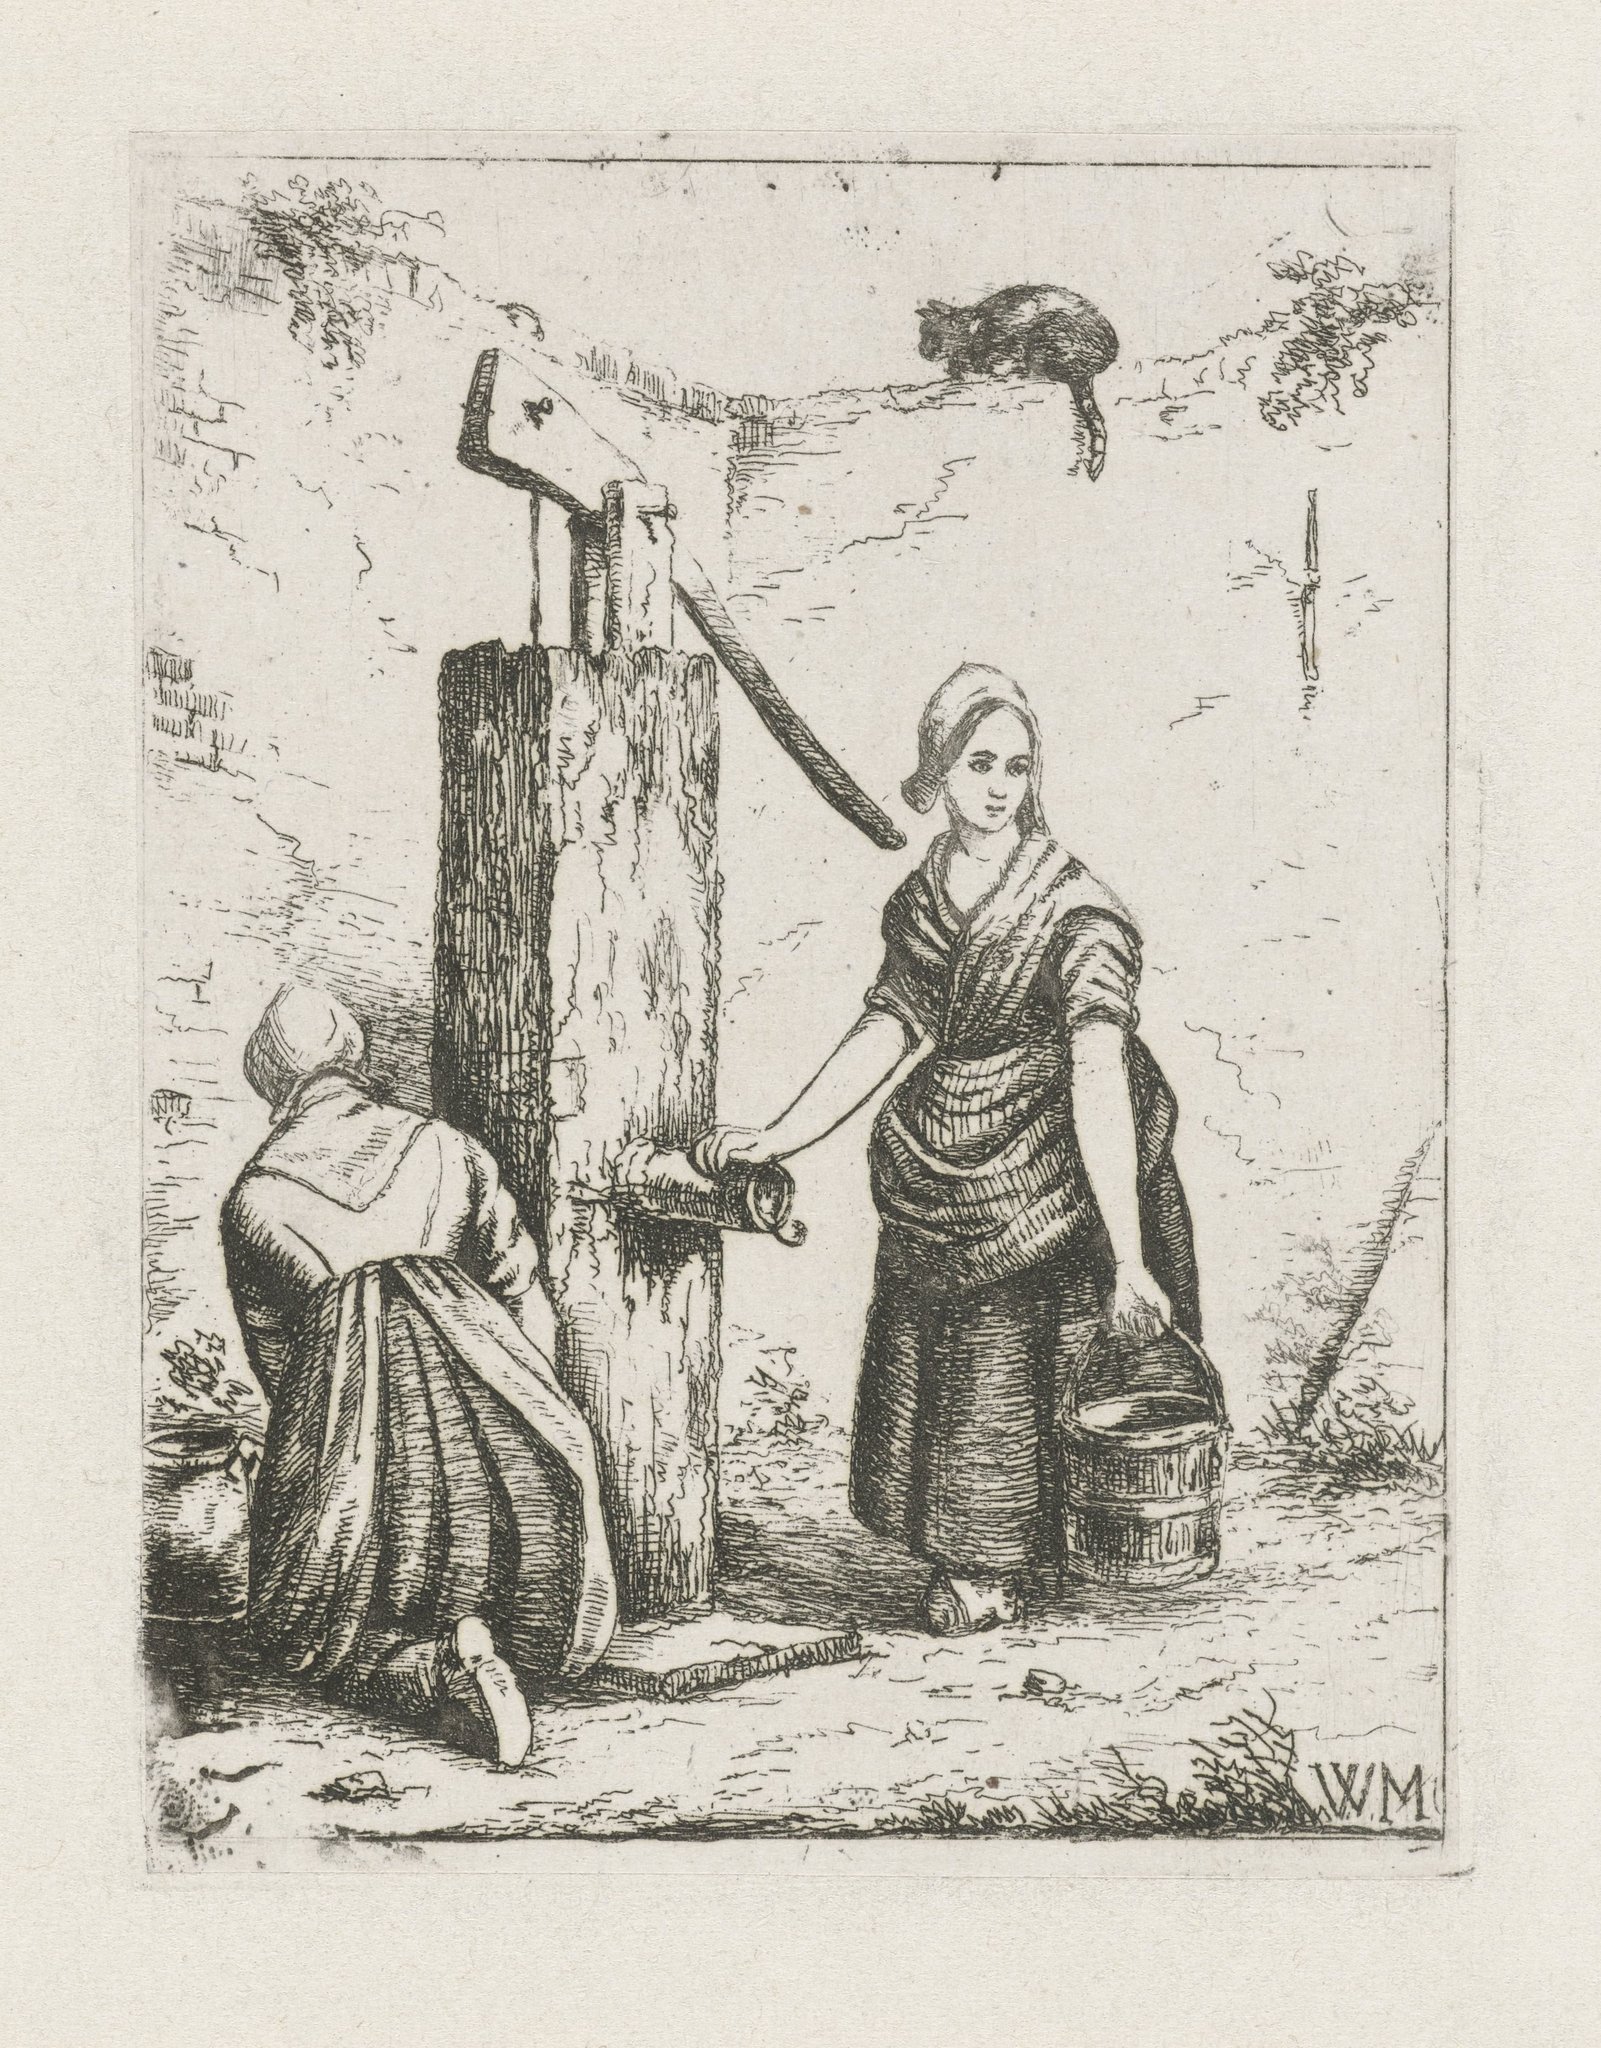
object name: print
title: Twee vrouwen bij een waterpomp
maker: christiaan wilhelmus moorrees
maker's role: draughtsman, print maker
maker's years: 1801-1867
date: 1811-1867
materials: paper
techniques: etching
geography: netherlands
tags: cat, utilitarian, public pump or water fountain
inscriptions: collector's mark: Lugt 2228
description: Twee vrouwen bij een waterpomp. De vrouw links geknield en op de rug gezien. Rechts een vrouw met een emmer.